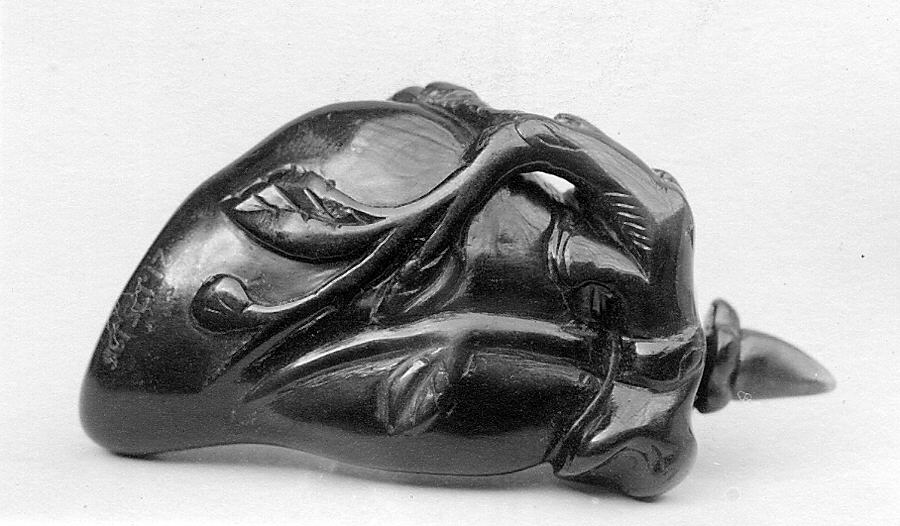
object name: snuff bottle with stopper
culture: chinese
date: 1736-1795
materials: amber